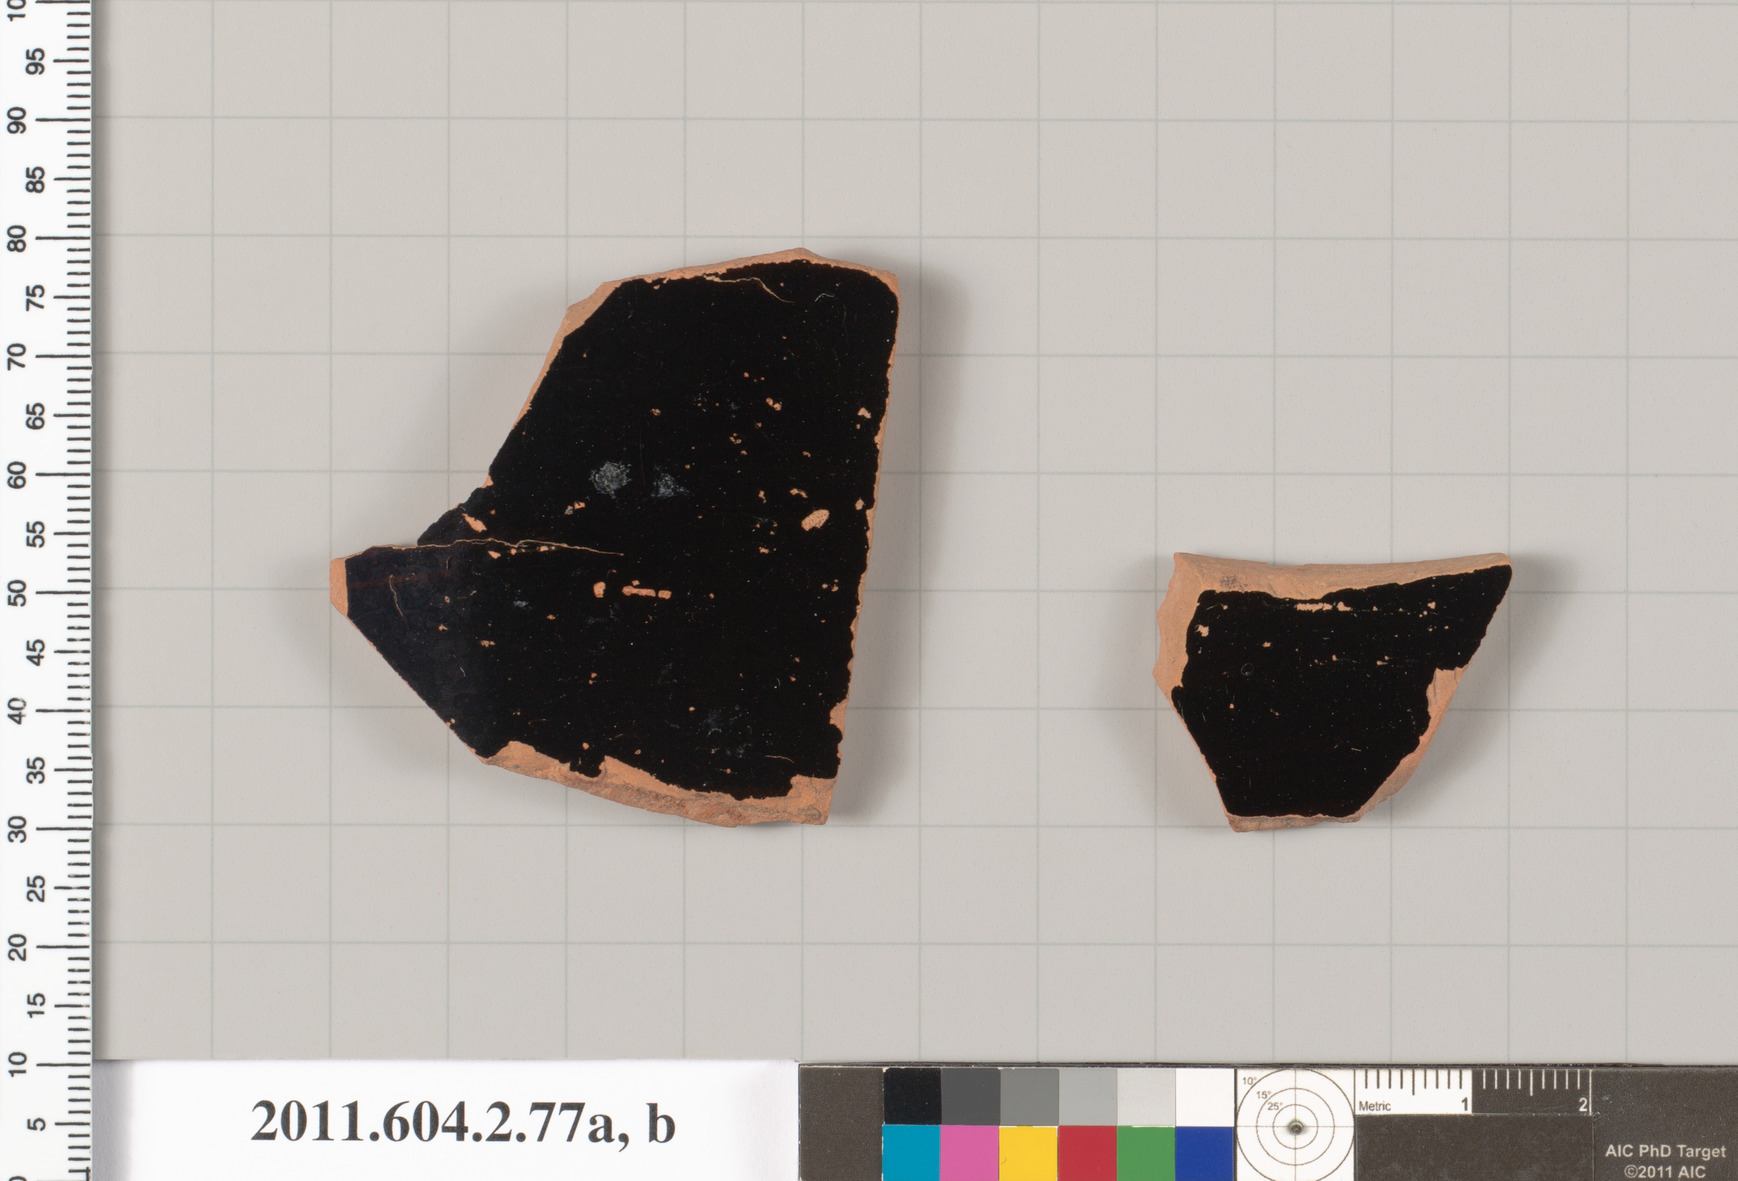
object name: amphora fragment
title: Terracotta fragments of an amphora (jar)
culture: greek, attic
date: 534-468 BCE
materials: terracotta